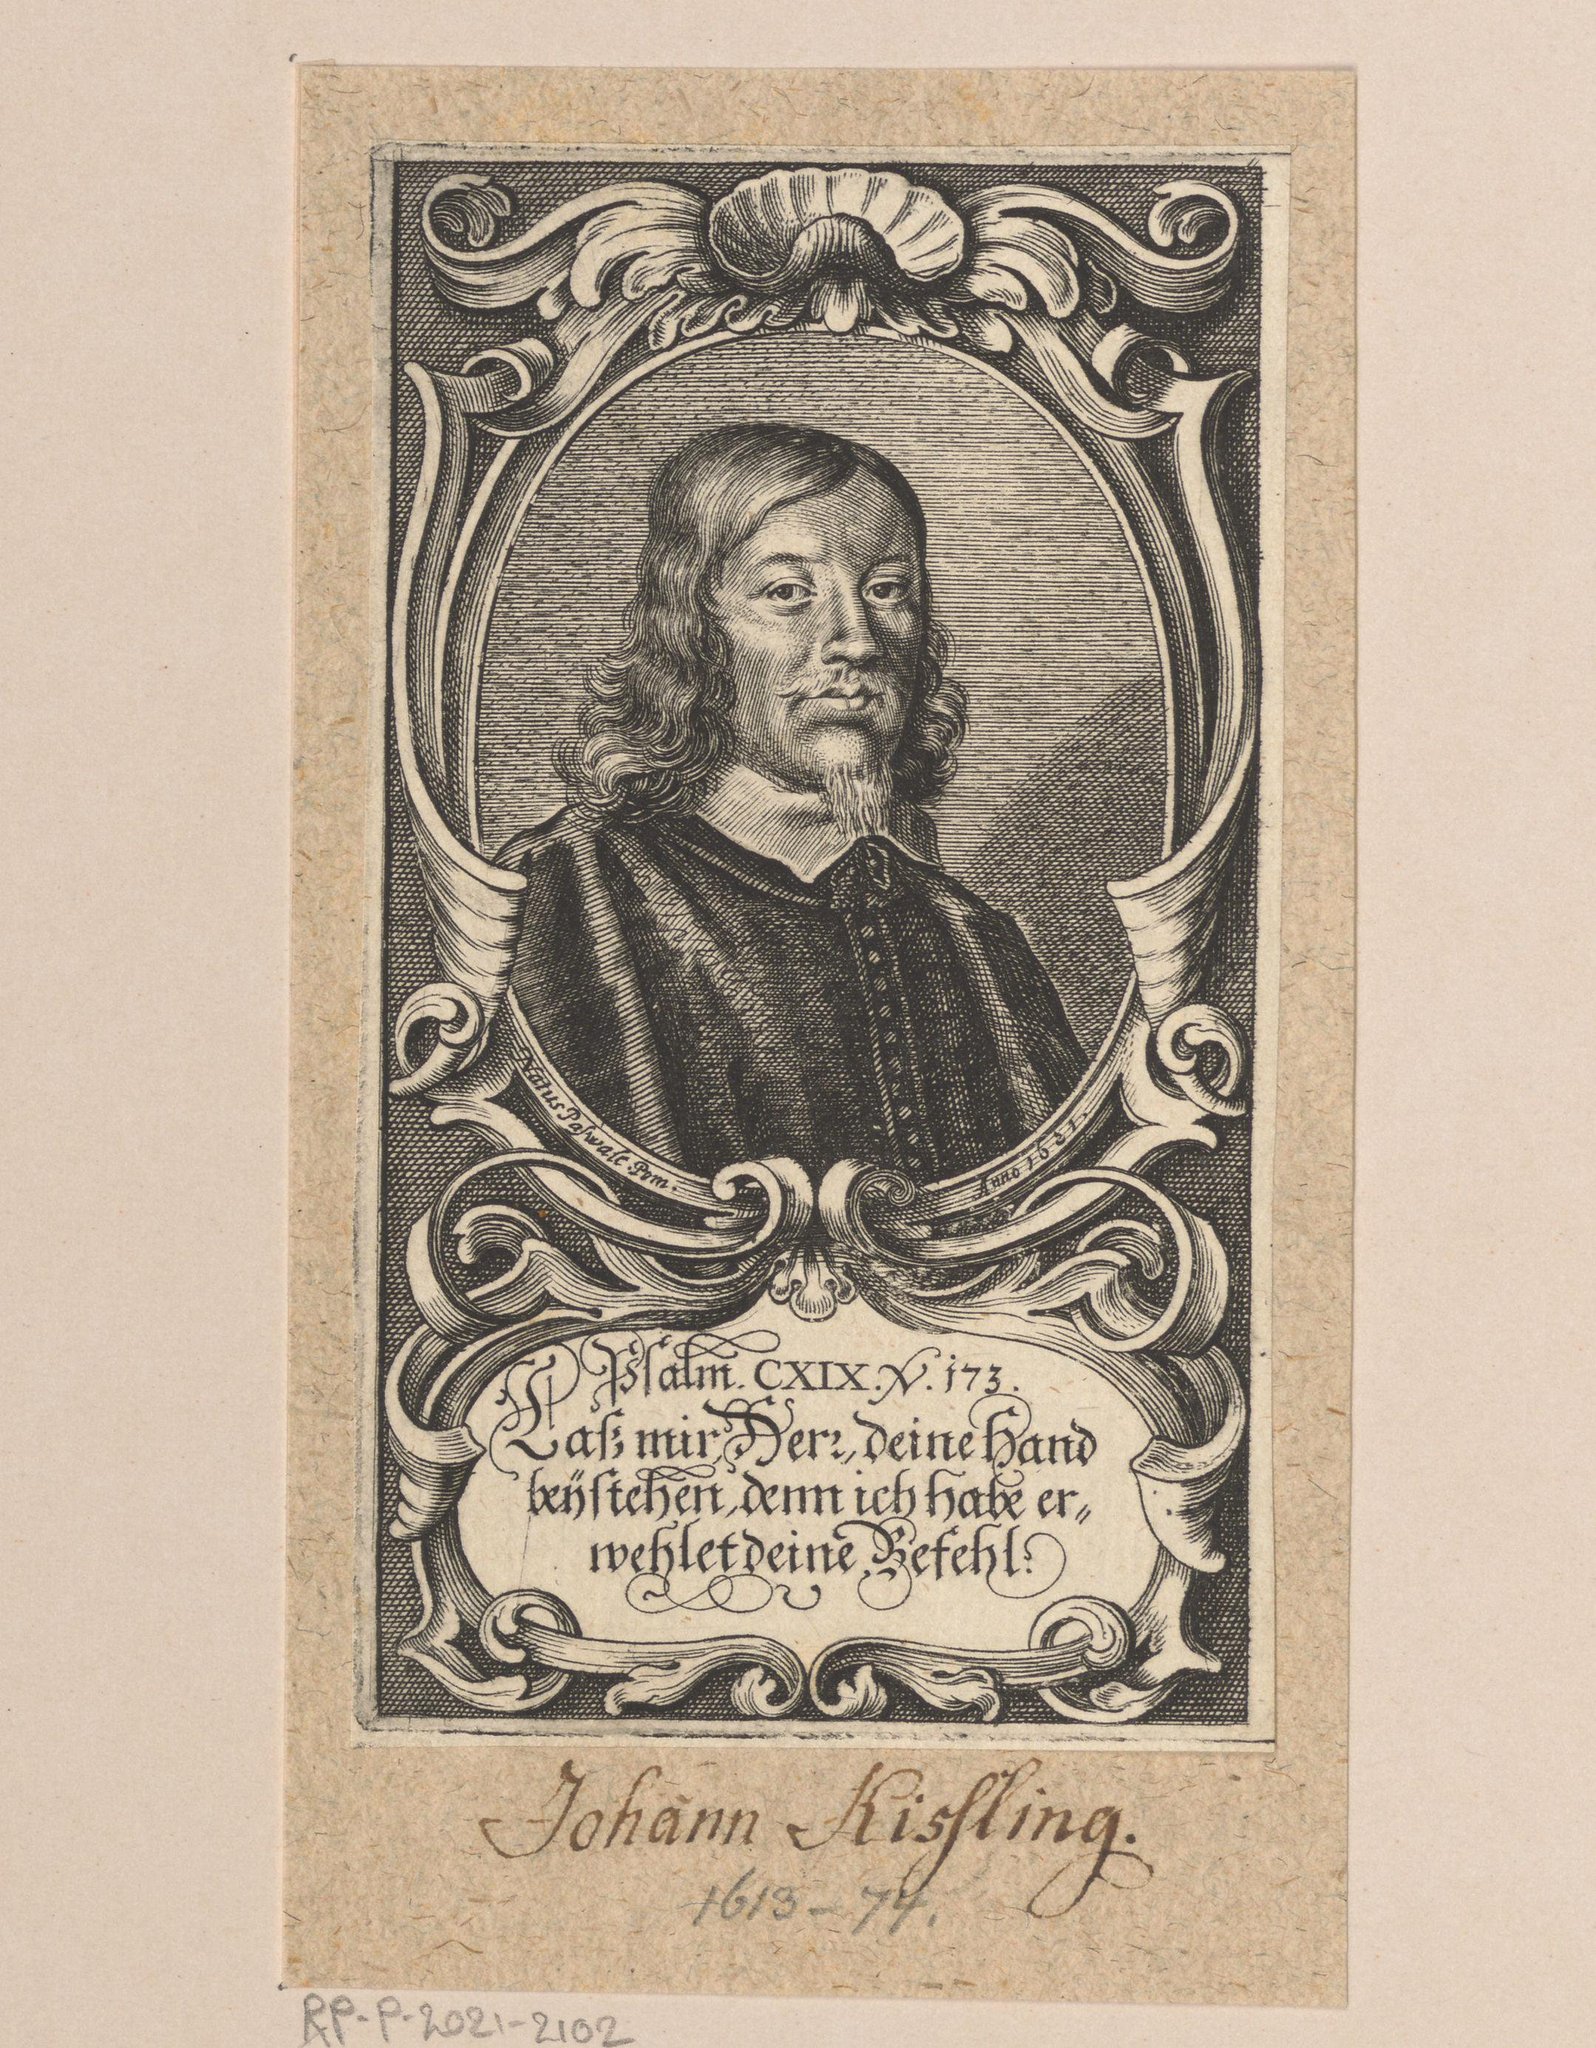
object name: print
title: Portret van Johann Kissling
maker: Anonymous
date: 1651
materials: paper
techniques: engraving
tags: historical persons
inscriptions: date